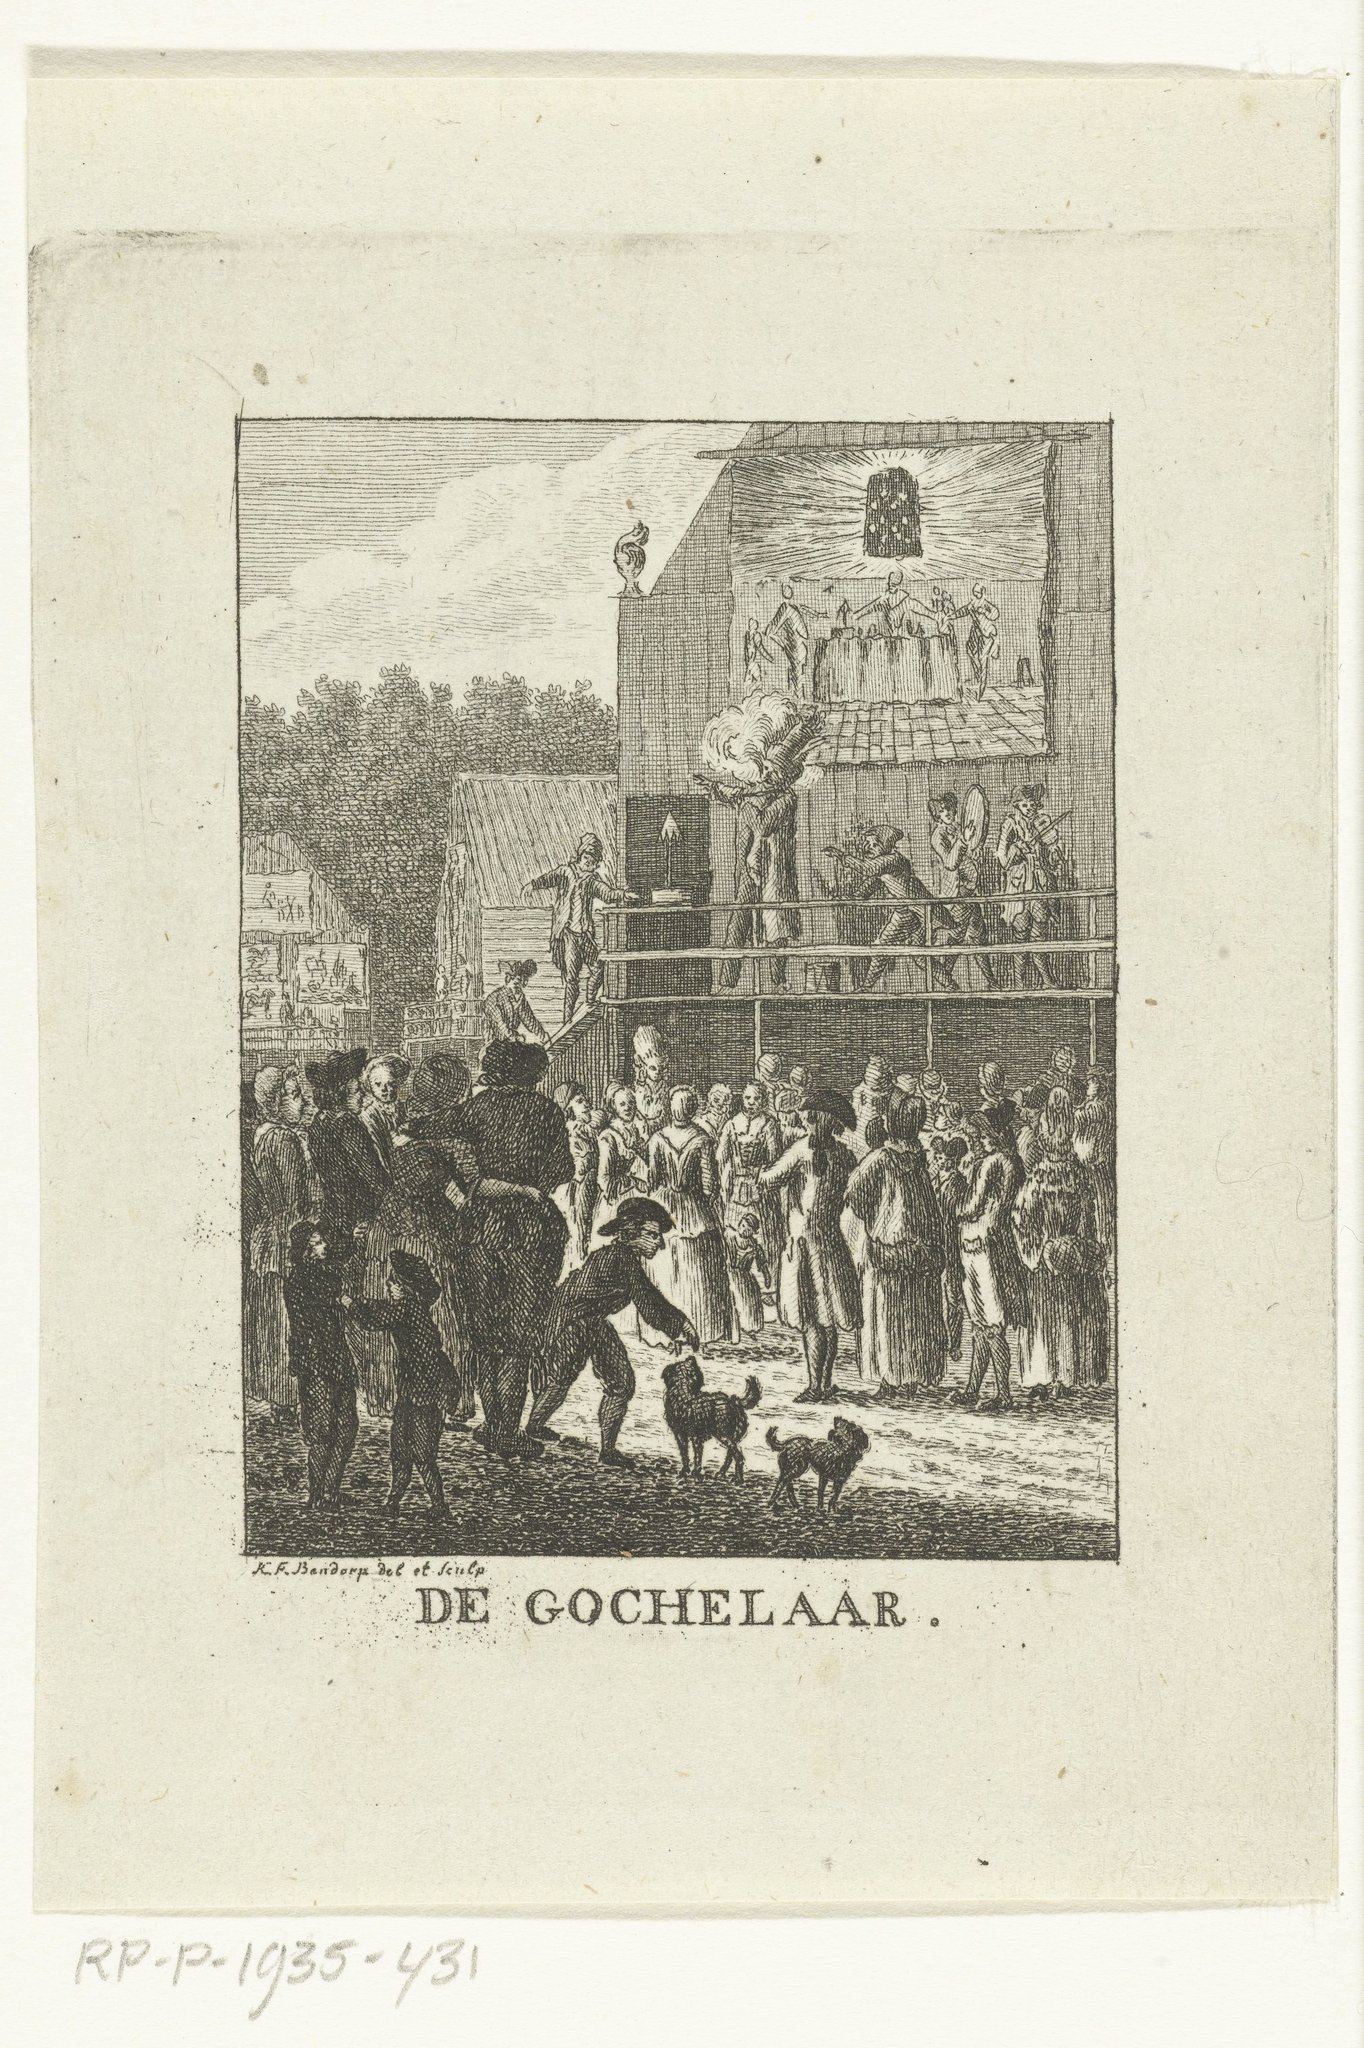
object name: print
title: Goochelaar treedt op voor publiek op kermis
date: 1782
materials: paper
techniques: etching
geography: netherlands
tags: illusionist, conjurer, juggler, 'legerdemain', performance in the open air (pleasure fair)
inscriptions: collector's mark: Lugt 2228, collector's mark: Lugt 2760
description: Prent uit: Vaderlandsche Kermisvreugd vertoond in acht kunstplaaten geteekend en gegraveerd door K.F. Bendorp, met toepasselijke Vaersjes door R. Arends, H. de Haas en Compagnie (uitgever) Dordrecht 1782